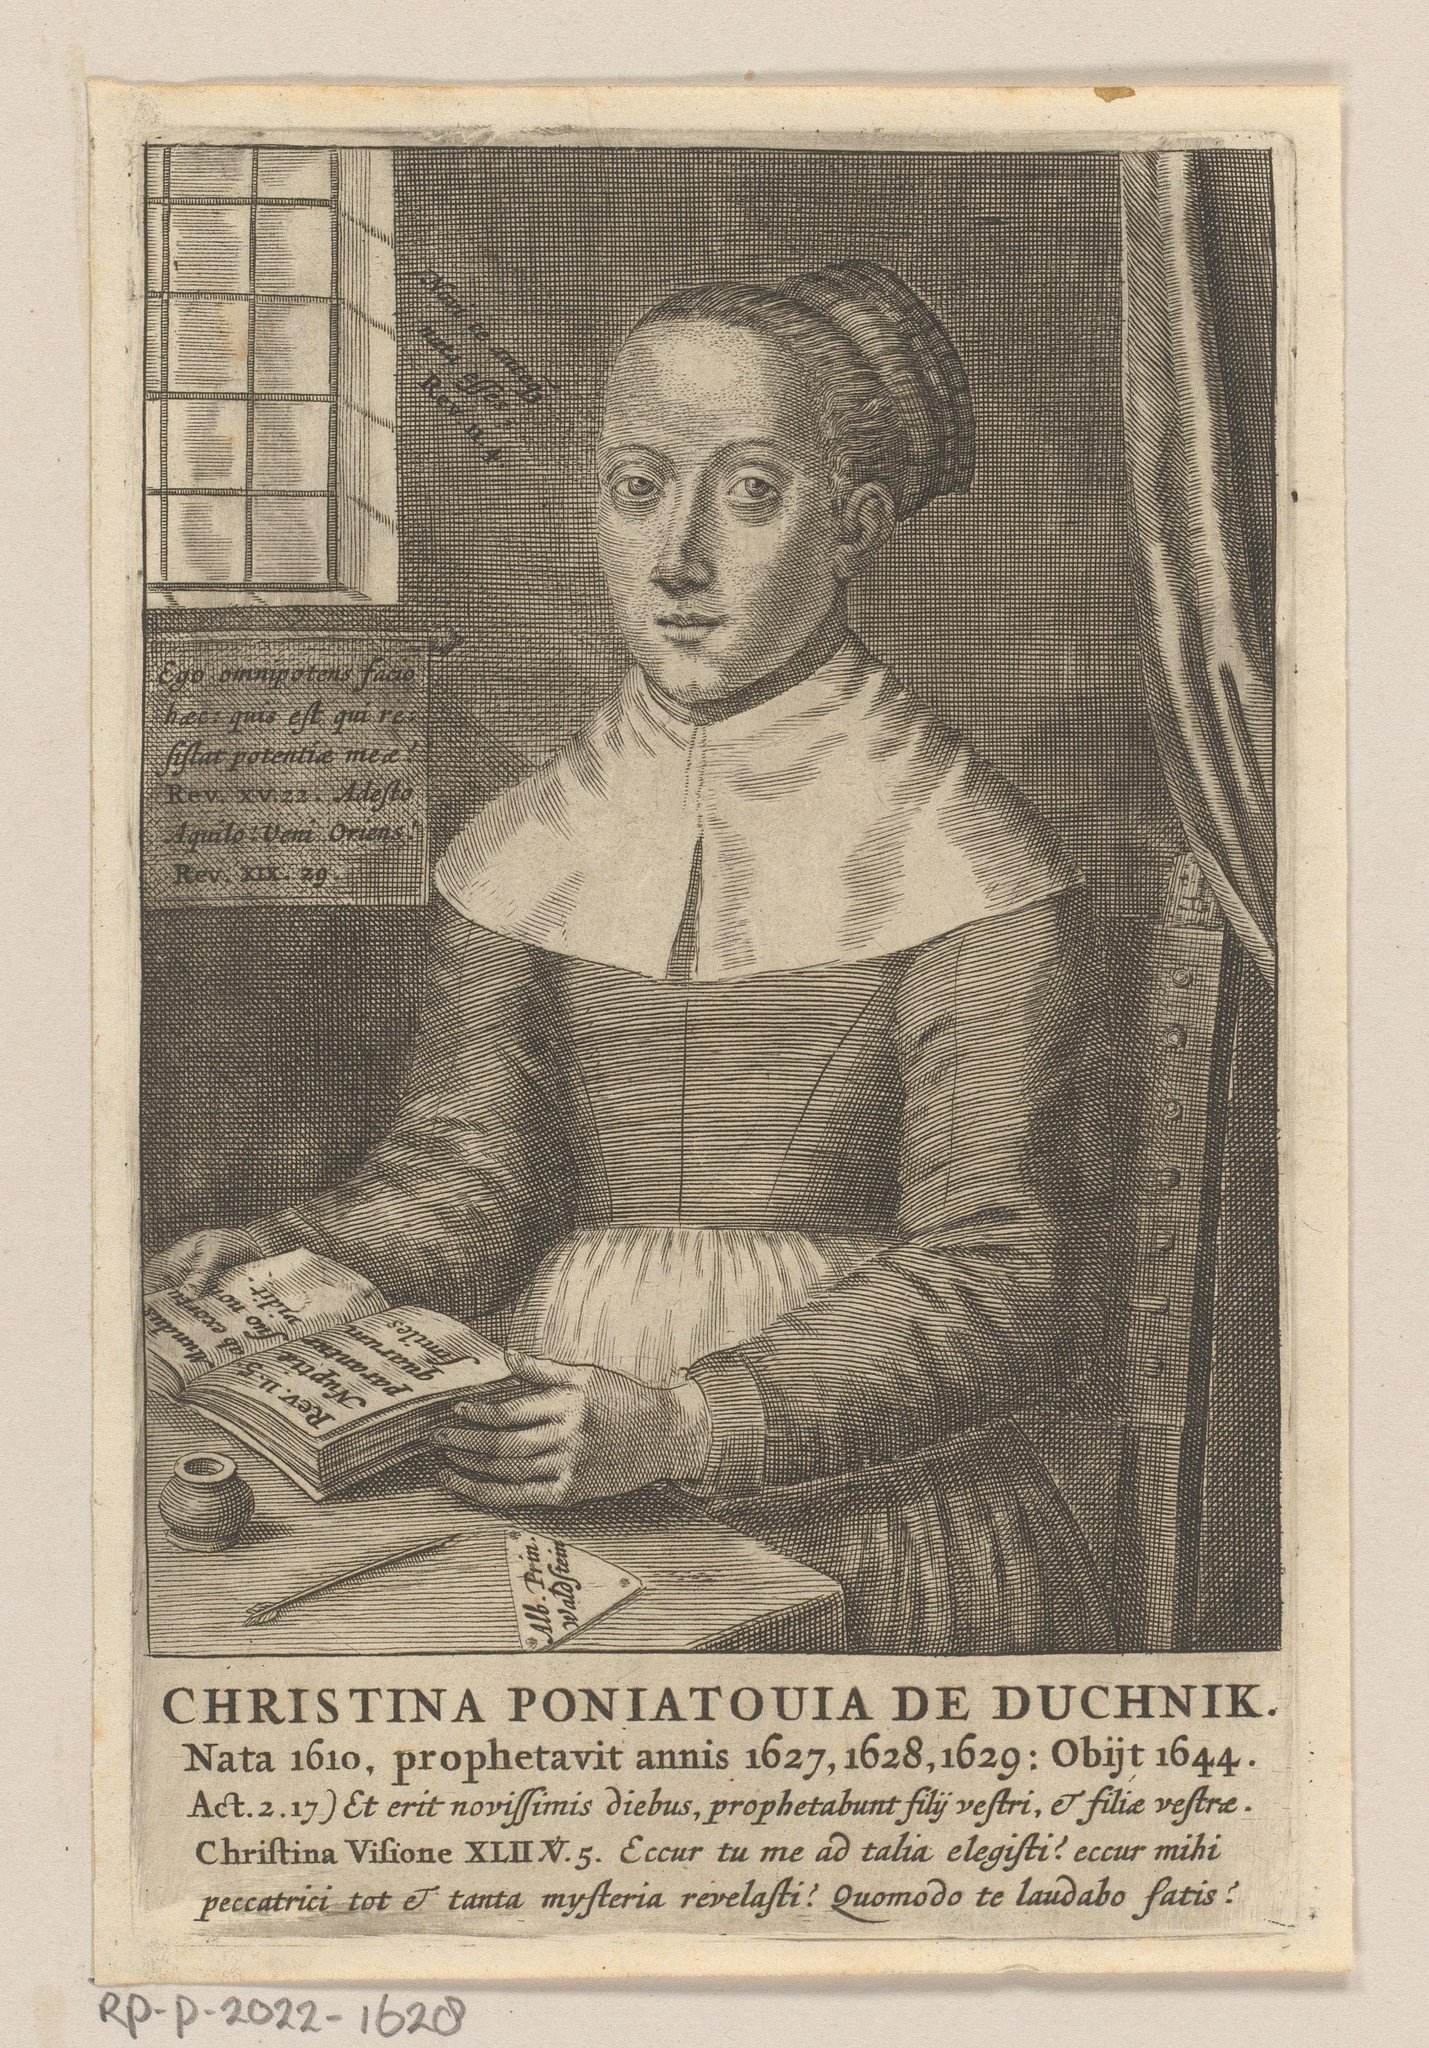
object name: print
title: Portret van Kristina Poniatowská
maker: Anonymous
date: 1644-1699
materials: paper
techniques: engraving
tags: historical persons - bb - woman, portrait of a writer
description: Met vierregelig onderschrift in het Latijn.